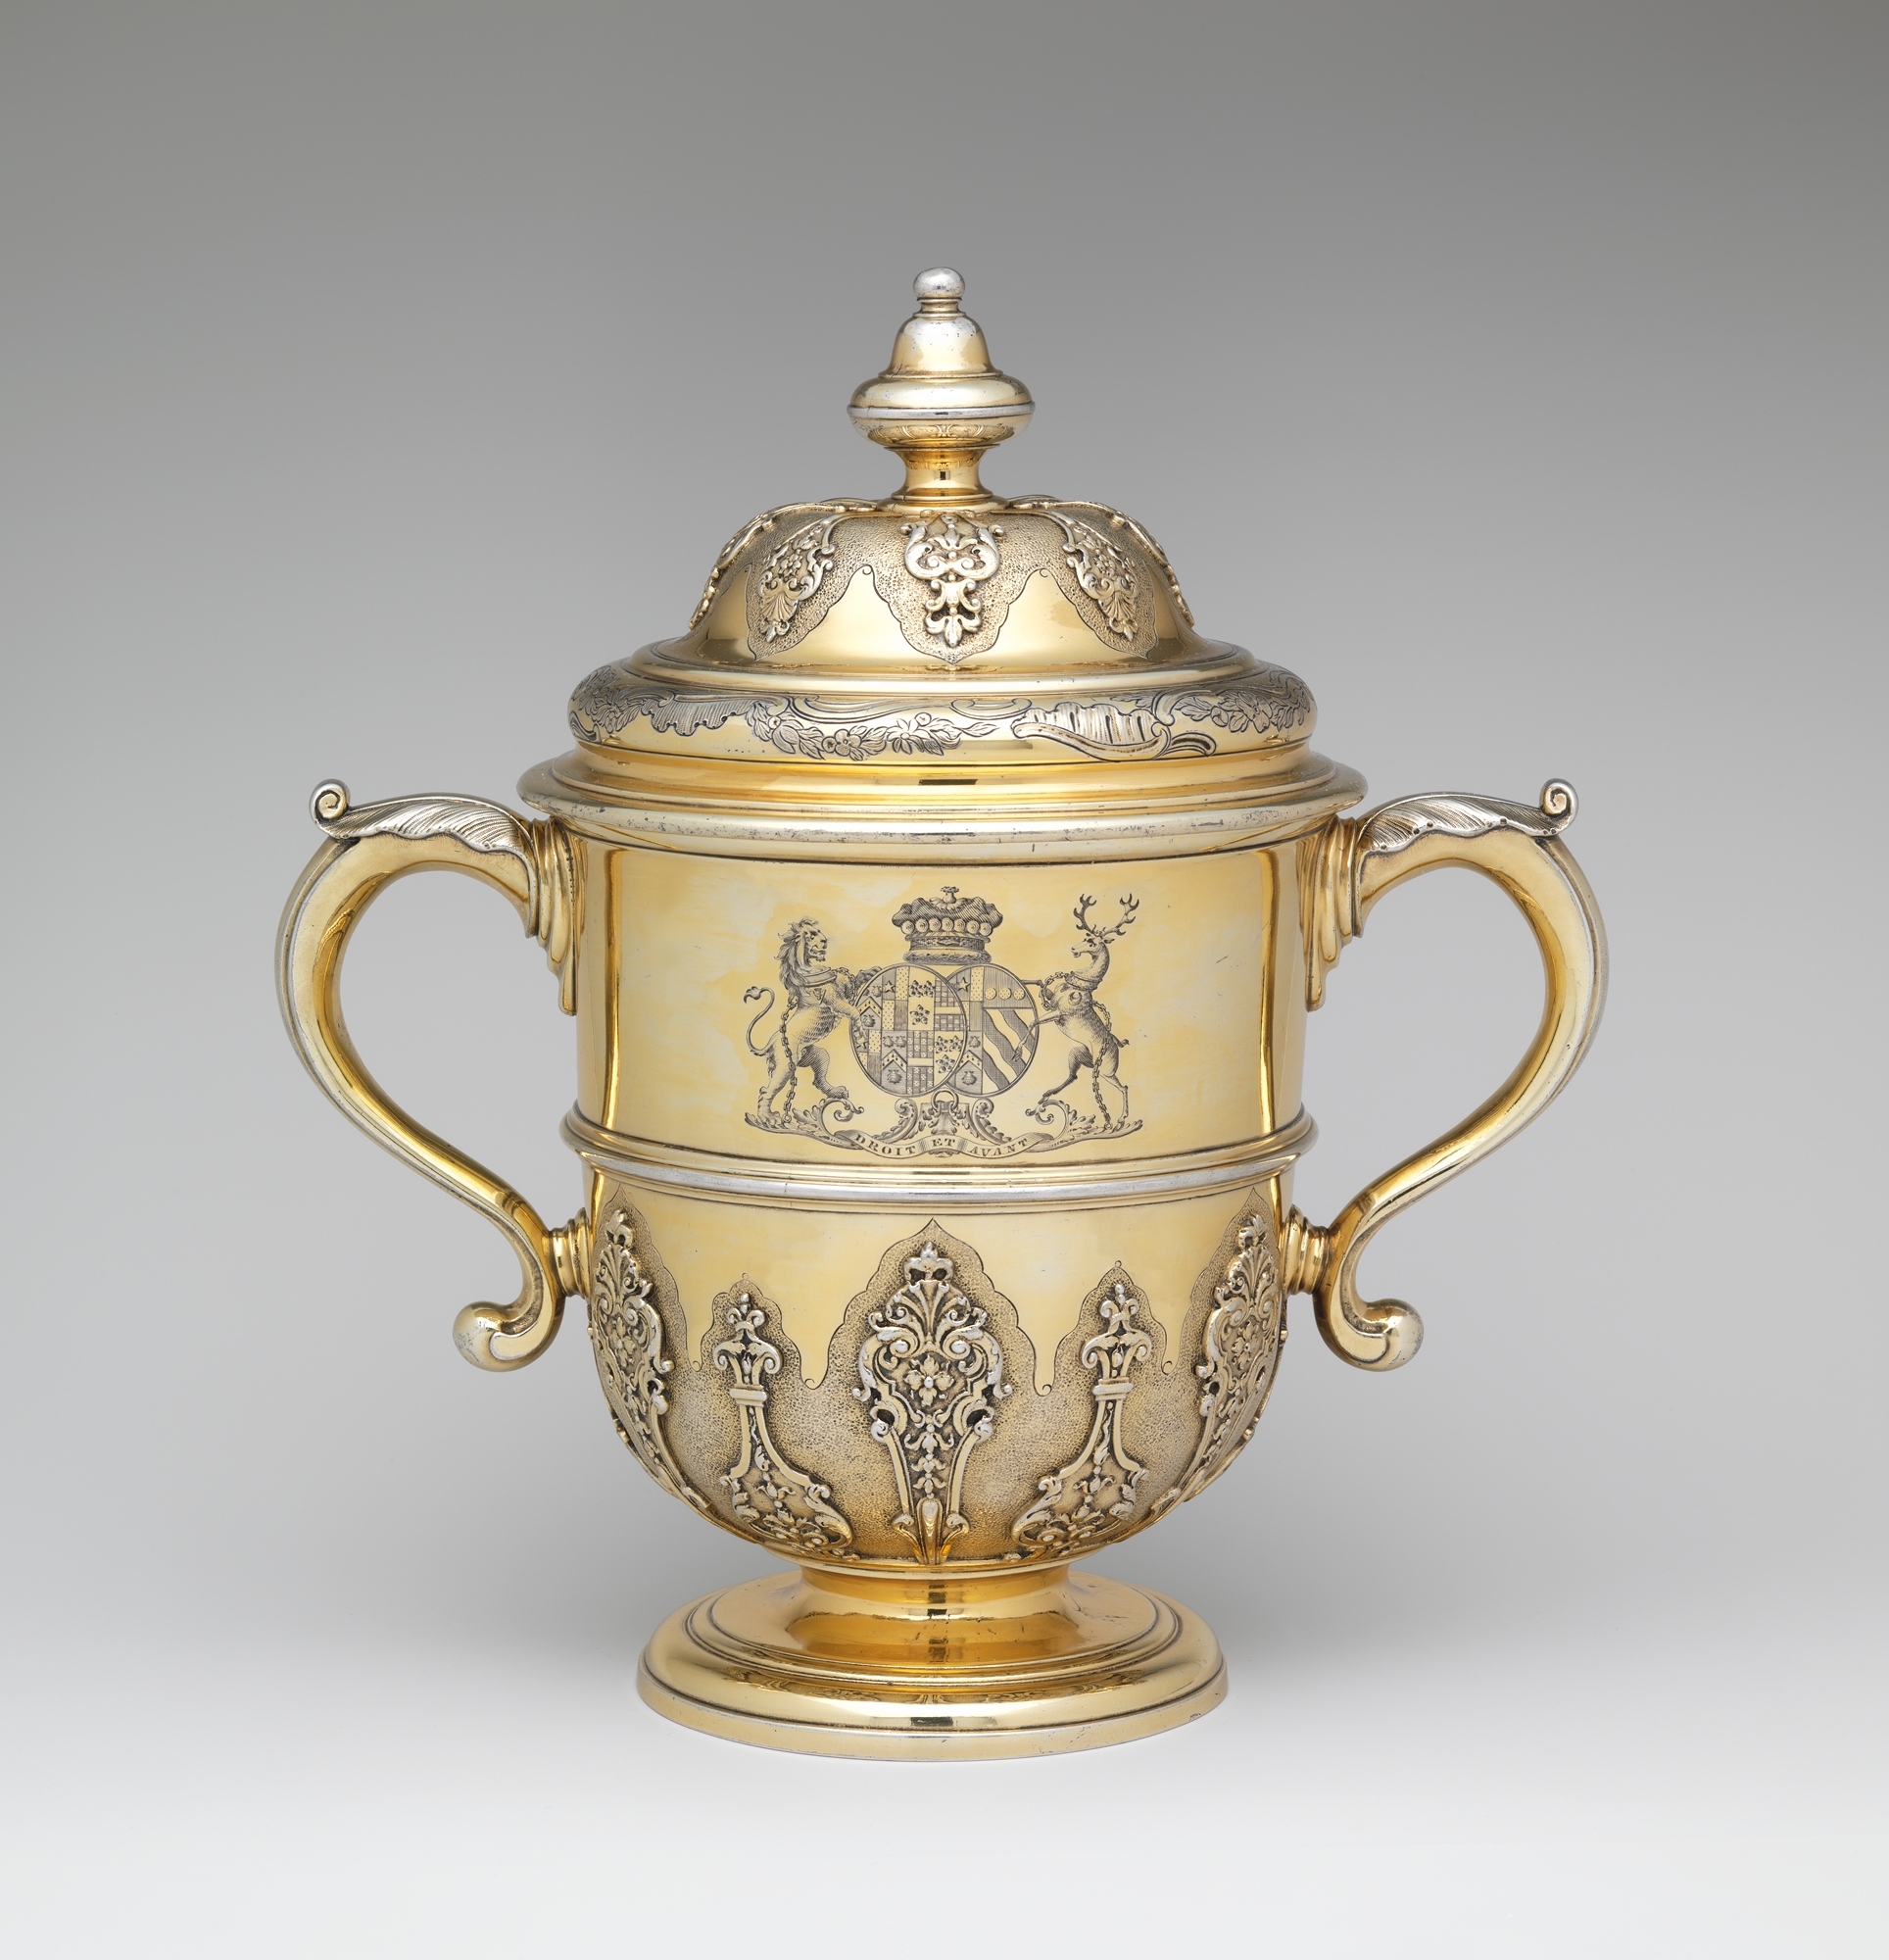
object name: cup with cover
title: Two-handled cup with cover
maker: thomas farren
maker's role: maker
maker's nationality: british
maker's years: 1703-1743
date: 1732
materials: silver gilt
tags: coat of arms